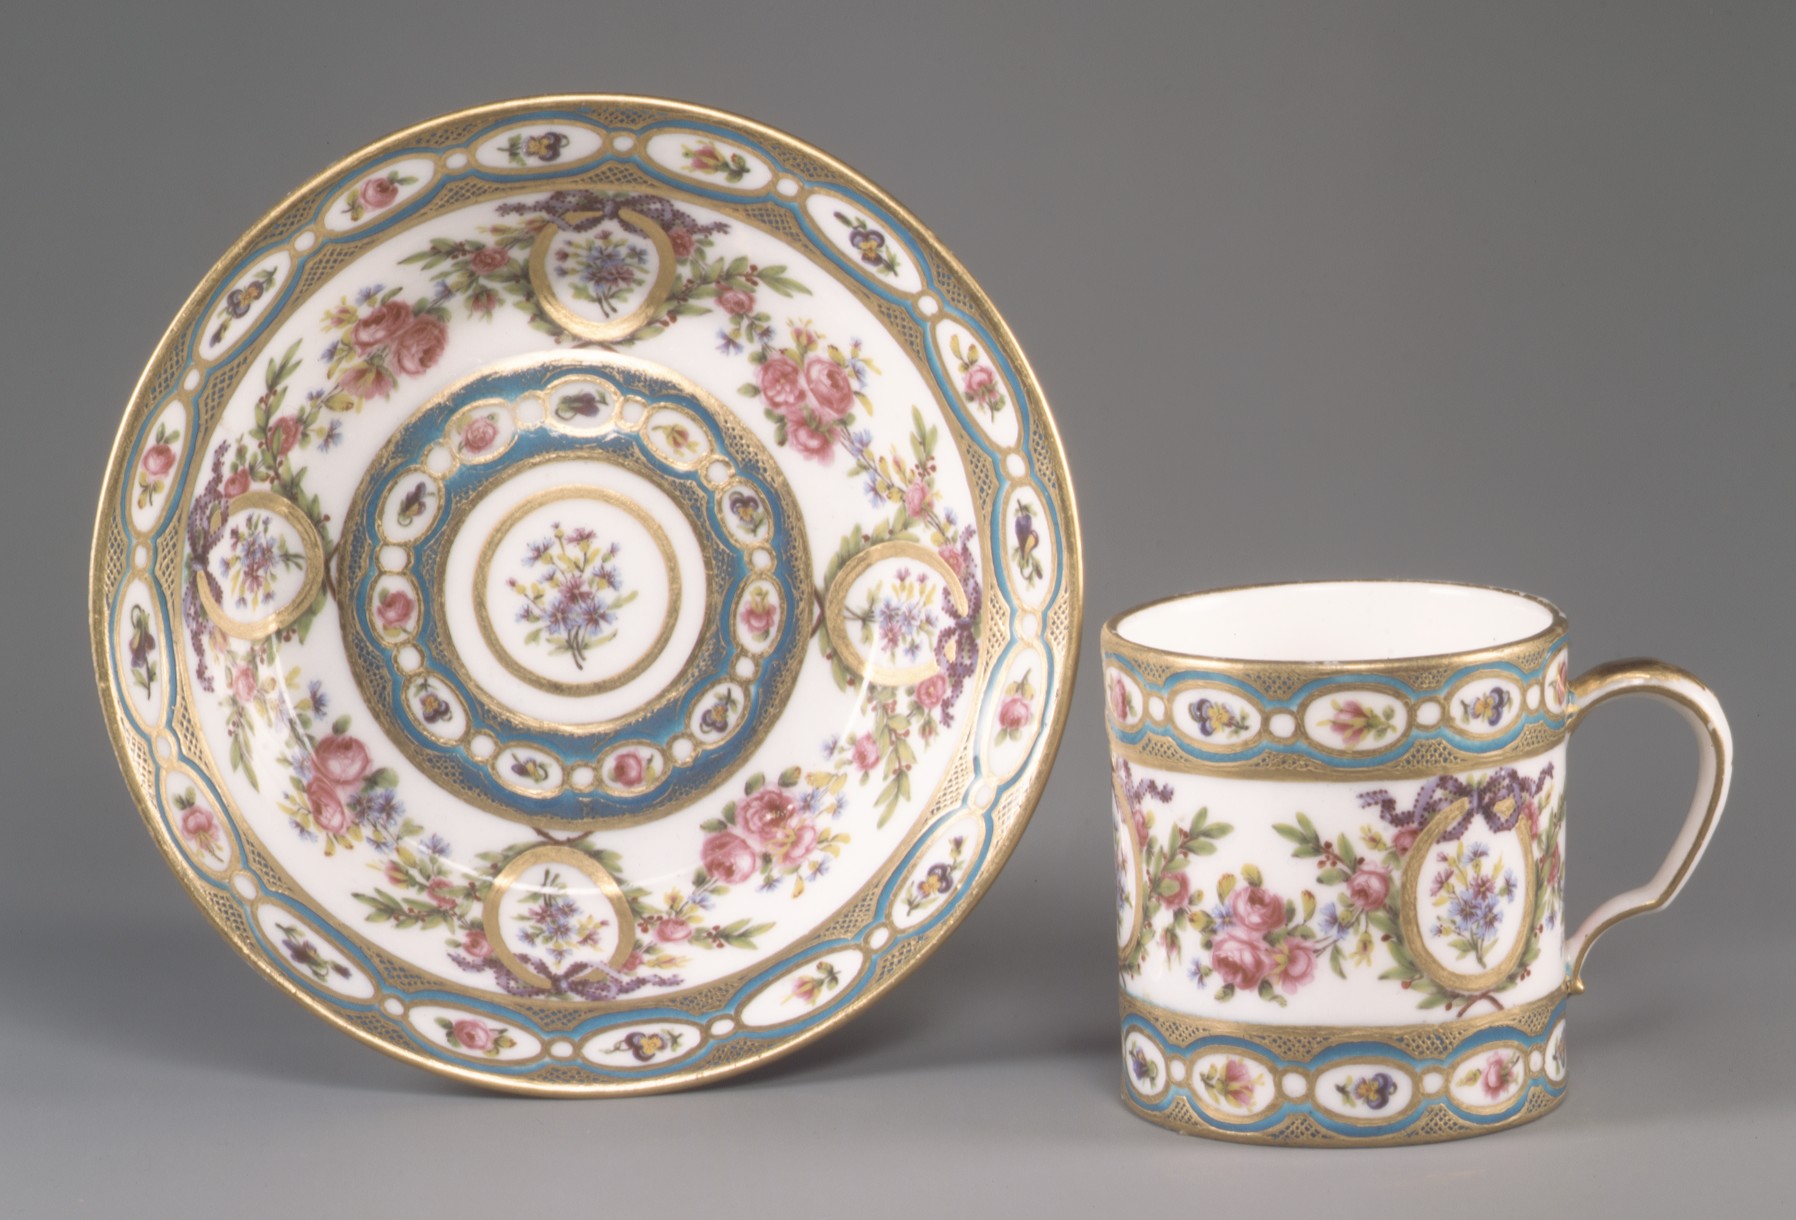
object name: cup and saucer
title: Cup and saucer (gobelet litron et soucoupe)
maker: sèvres manufactory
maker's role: manufactory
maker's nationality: french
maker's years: 1740-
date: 1780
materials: soft paste porcelain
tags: flowers